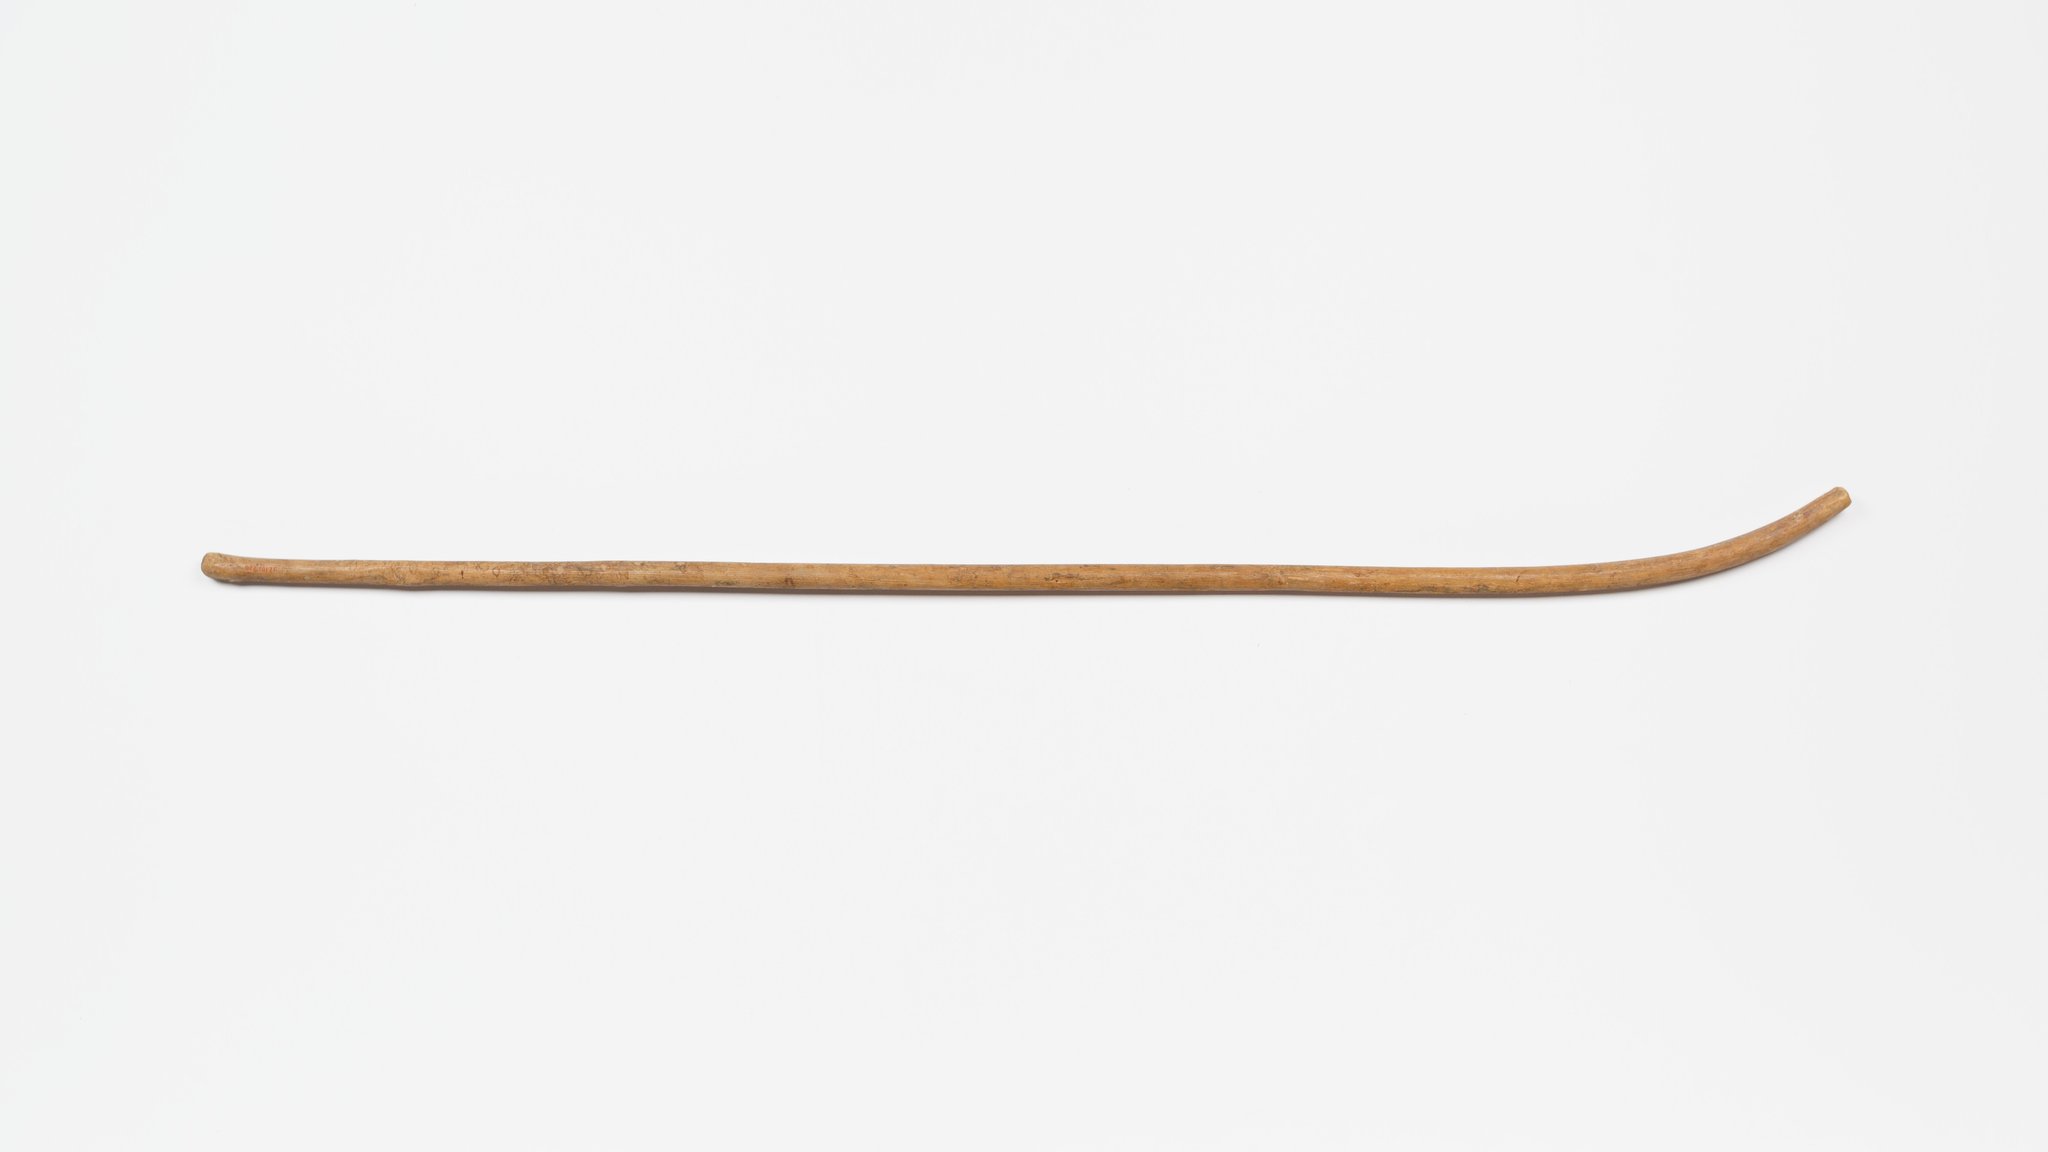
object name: staff, curved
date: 1550-1295 BCE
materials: wood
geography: egypt